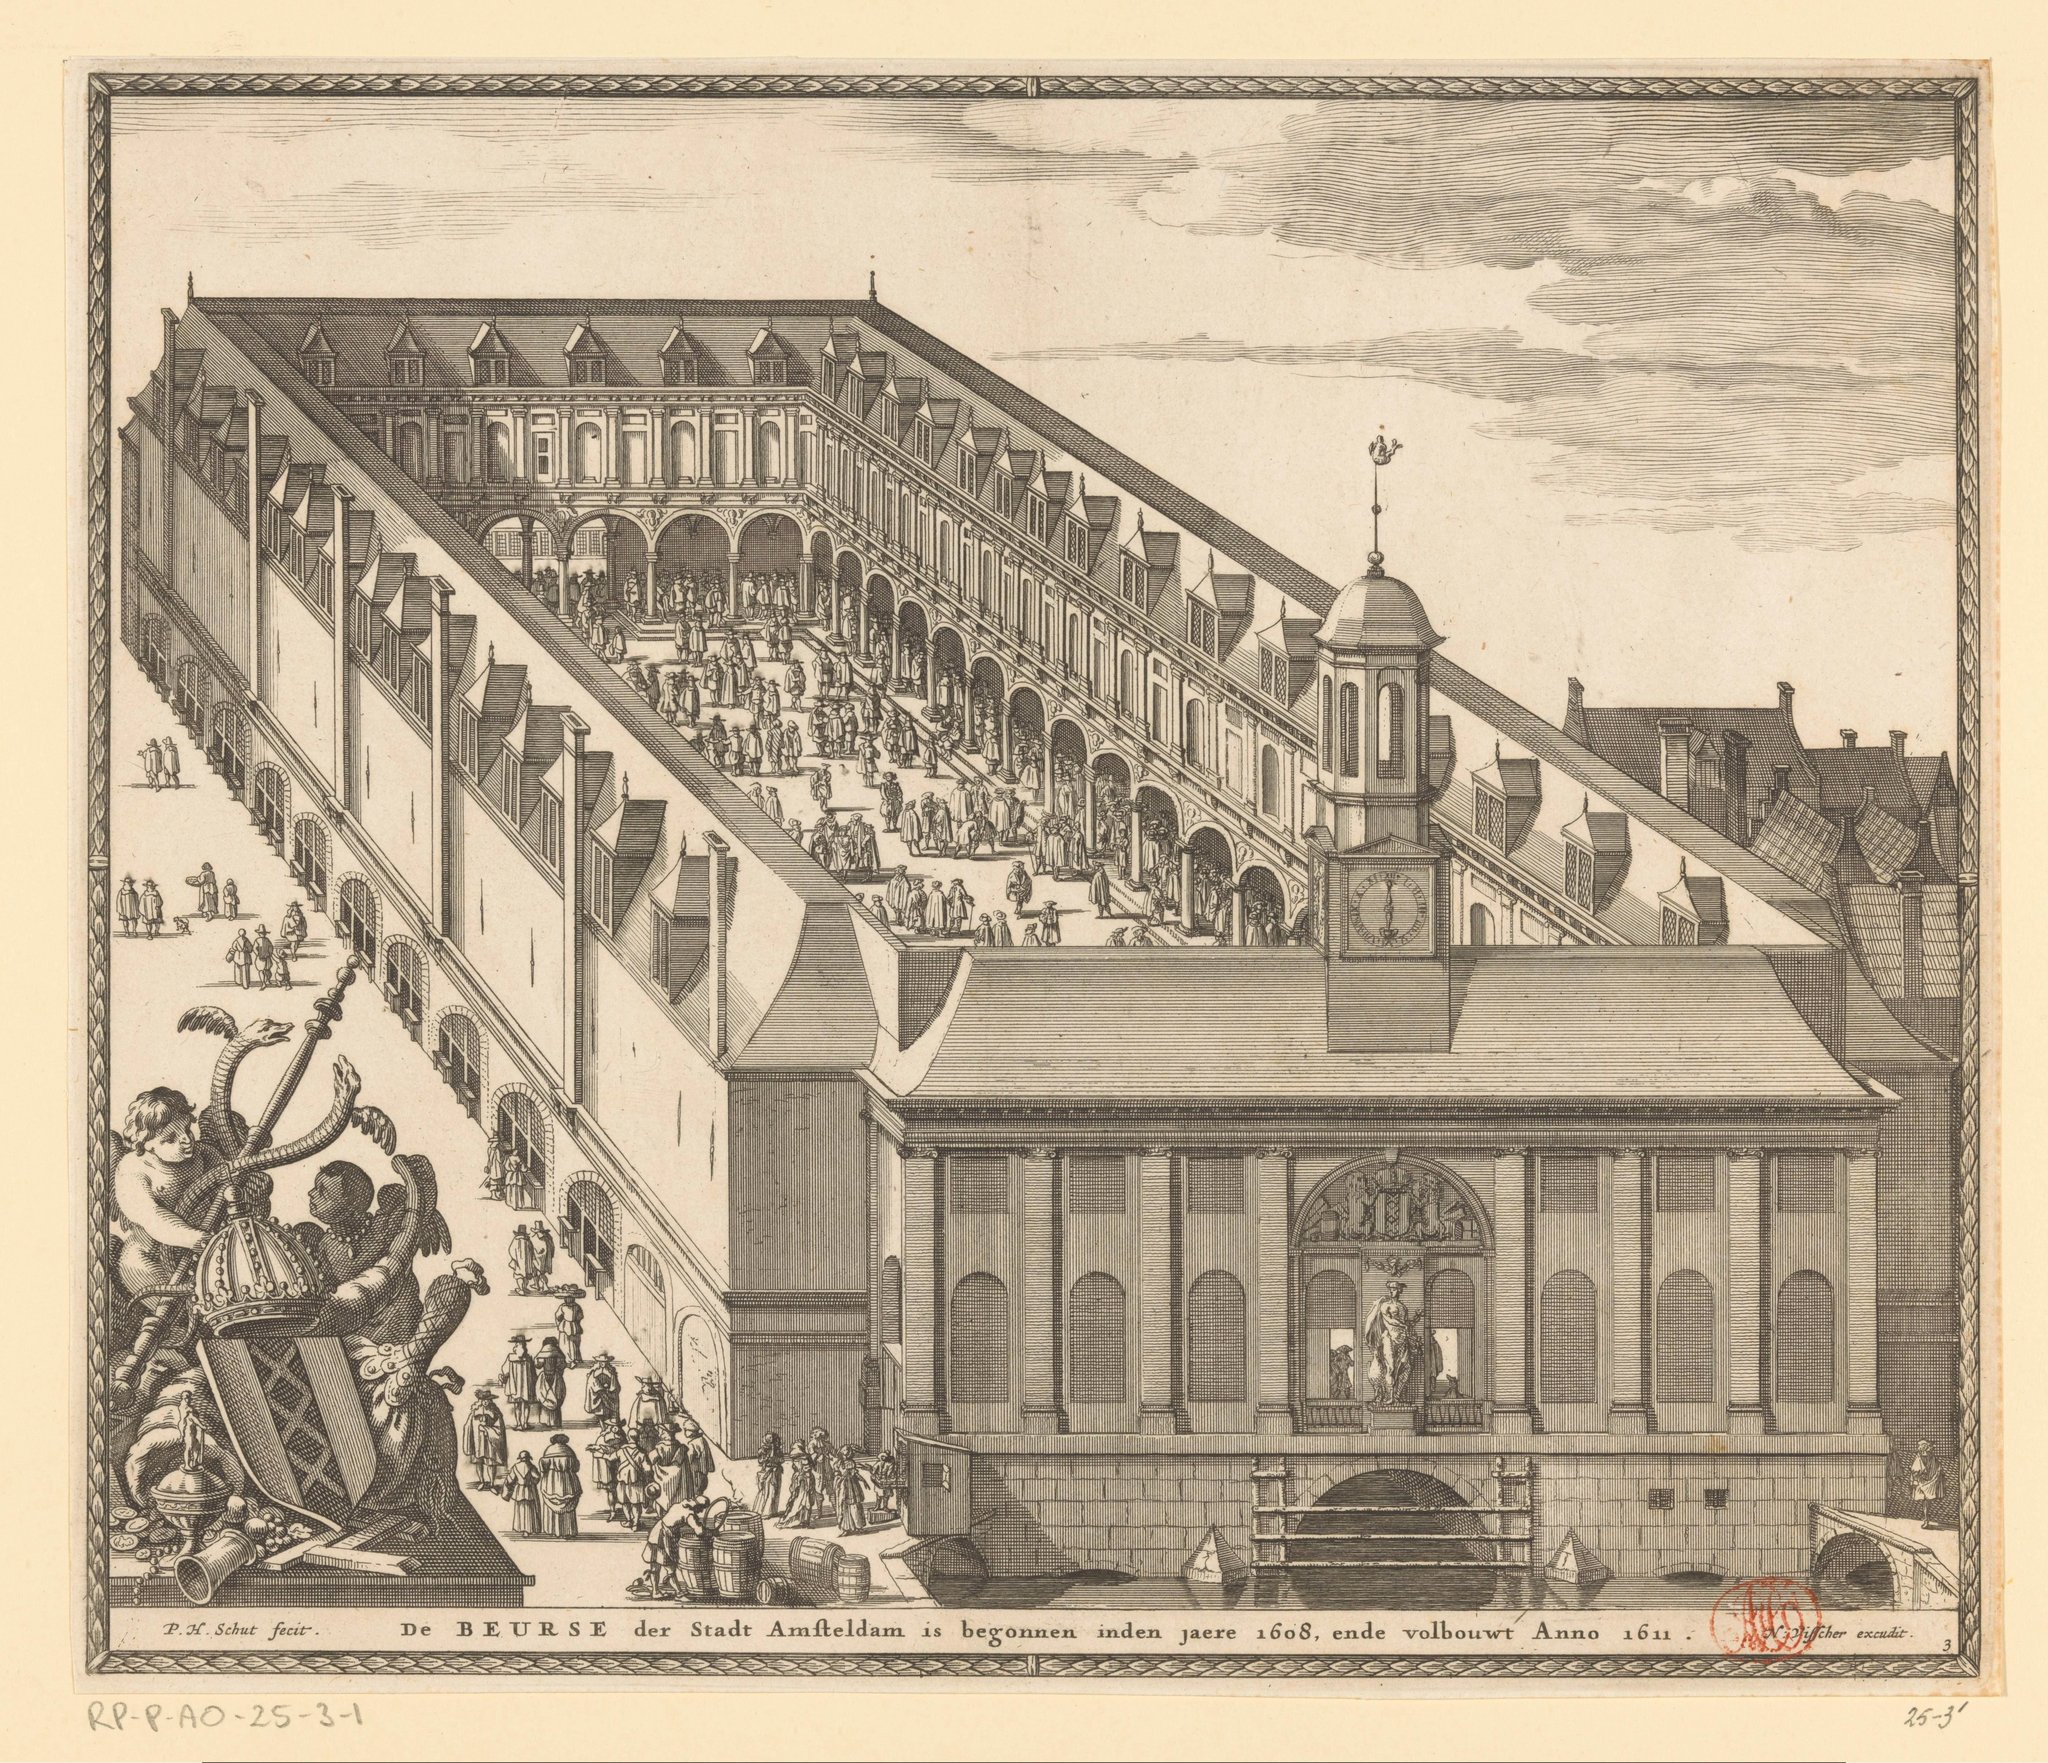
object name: print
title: De Beurse der Stadt Amsteldam is begonnen inden jaere 1608, ende volbouwt Anno 1611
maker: pieter hendricksz. schut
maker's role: print maker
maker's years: 1618-1660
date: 1668-1720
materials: paper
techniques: engraving, etching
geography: amsterdam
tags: purse, money-bag, coat of arms (as symbol of the state, etc.) (+ city; municipal), bridge in city across river, canal, etc. (+ city(-scape) with figures, staffage), 'cornucopia', horn of plenty, stock exchange, stock-market, courtyard, caduceus (staff with two snakes, attribute of mercury), street (+ city(-scape) with figures, staffage)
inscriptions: collector's mark: Lugt 195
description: Vogelvluchtgezicht op de Beurs van Hendrik de Keyser te Amsterdam, na de verbouwing van 1668. m. In en om het gebouw vele figuren. Linksonder het wapen van de stad met daaromheen twee putti met een caduceus, een hoorn des overvloeds waar kostbaarheden uit vloeien en een geldbeurs. Rechtsonder genummerd: 3.